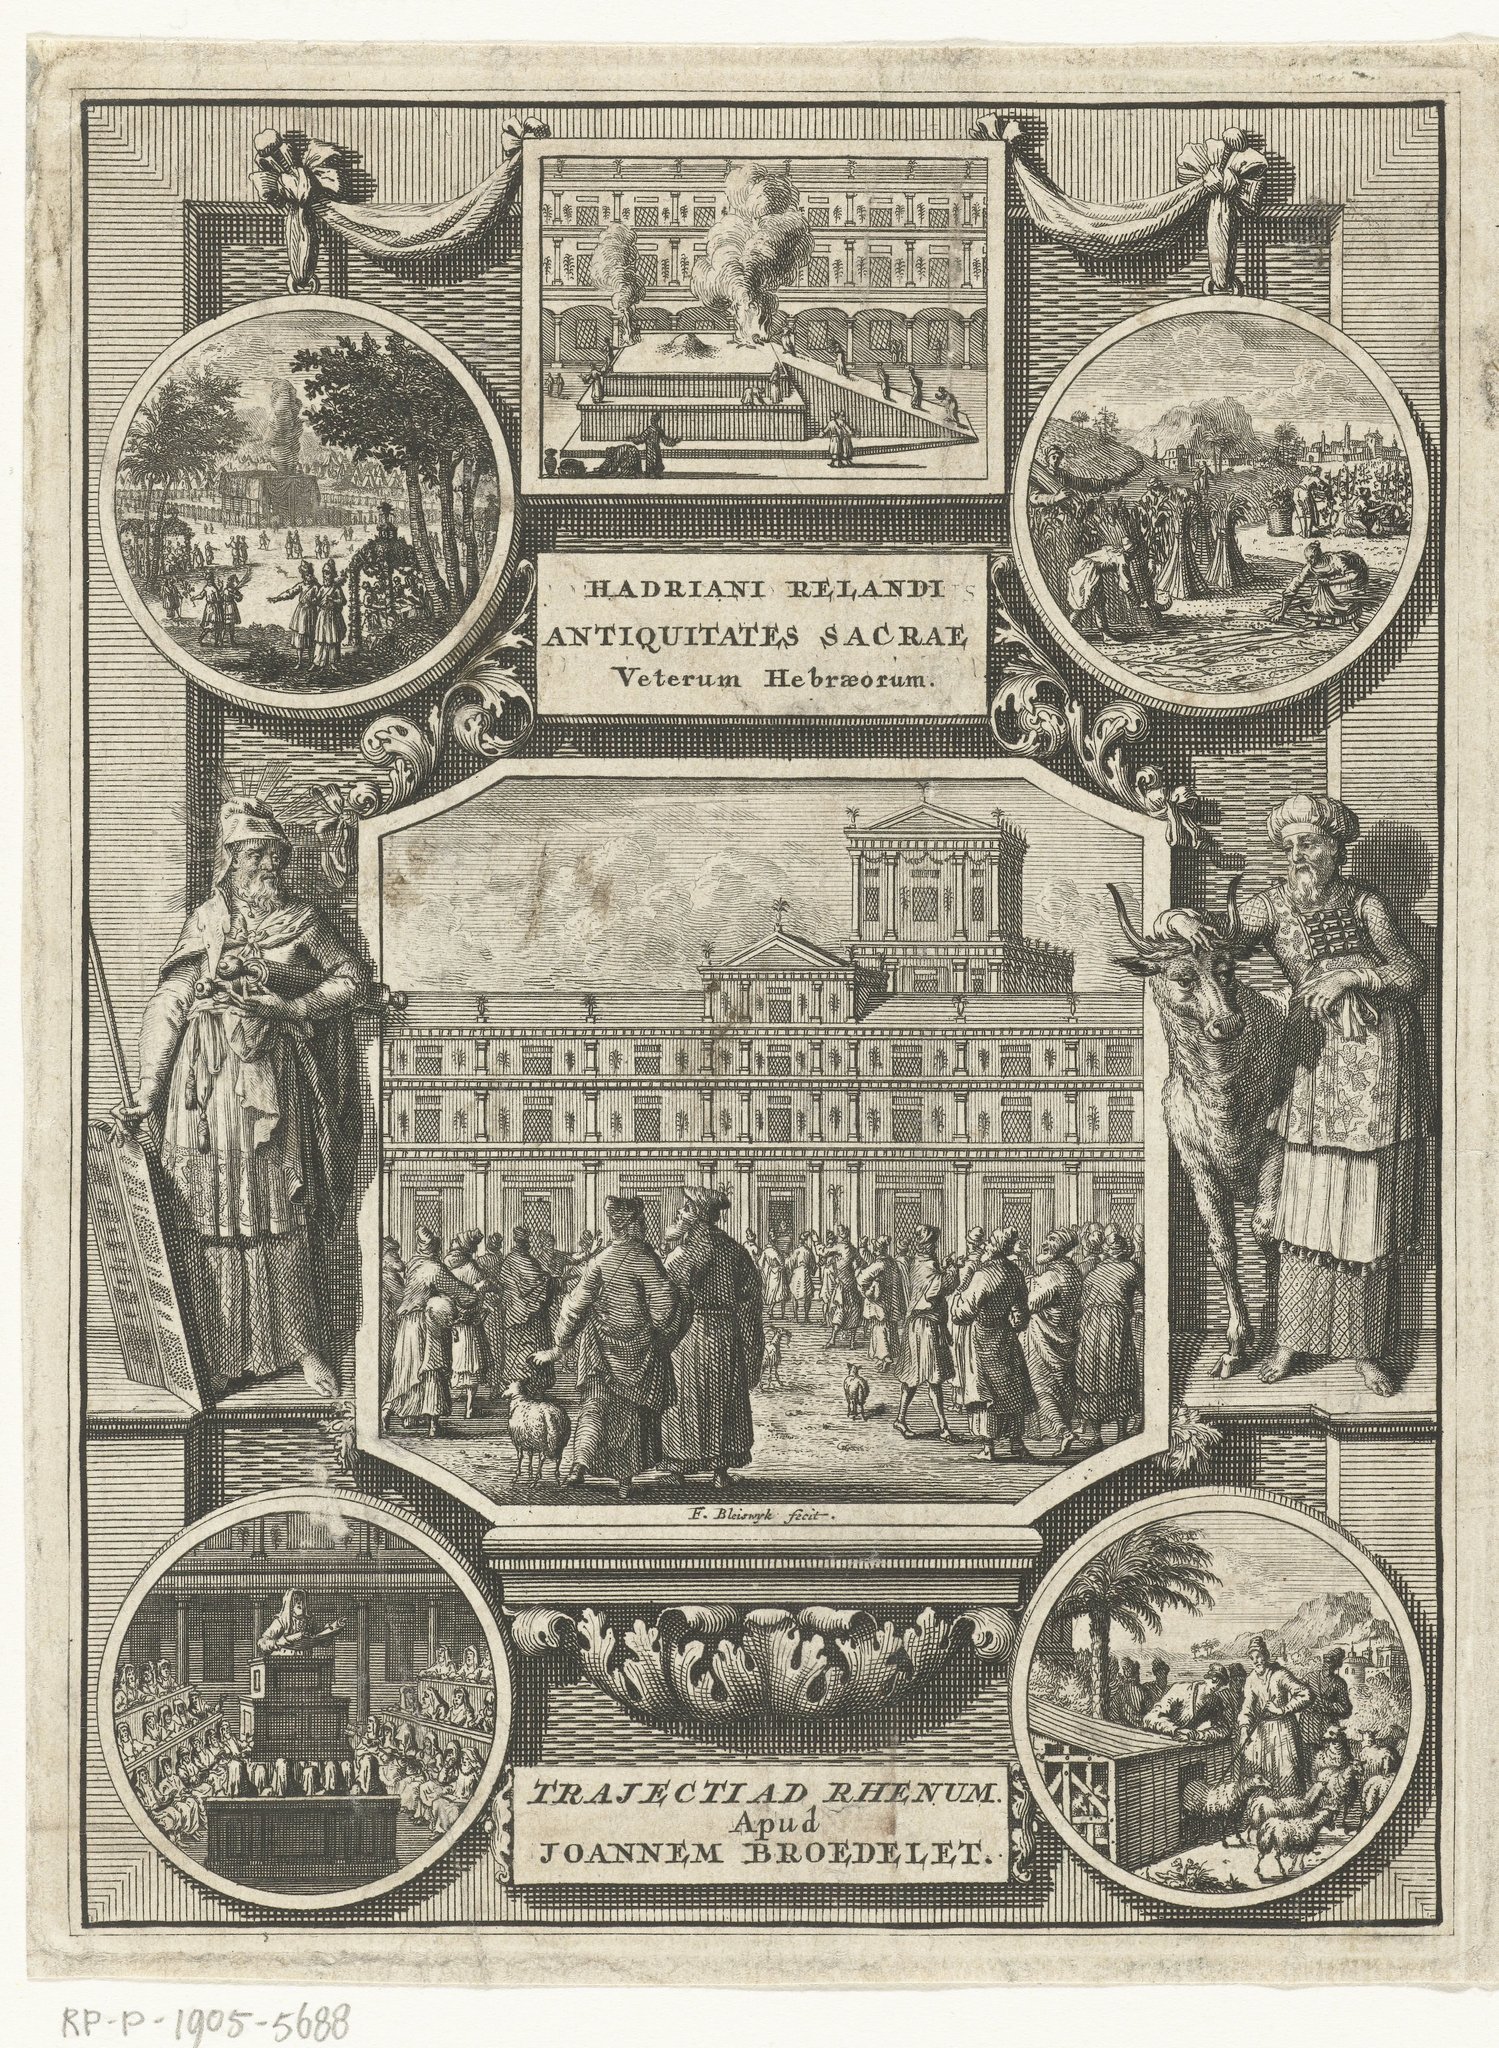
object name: print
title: Scènes uit geschiedenis van Joodse geloof en het Oude Testament in omlijsting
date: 1681-1708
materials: paper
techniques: etching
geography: utrecht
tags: high priest ~ hierarchy of priests, tabernacle, 'mishkan' ~ jewish religion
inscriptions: collector's mark: Lugt 2228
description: Titelpagina voor: Adriaan Reland, Antiquitates sacrae veterum Hebraeorum, Utrecht, Johannes Broedelet, 1708 (eerste druk).